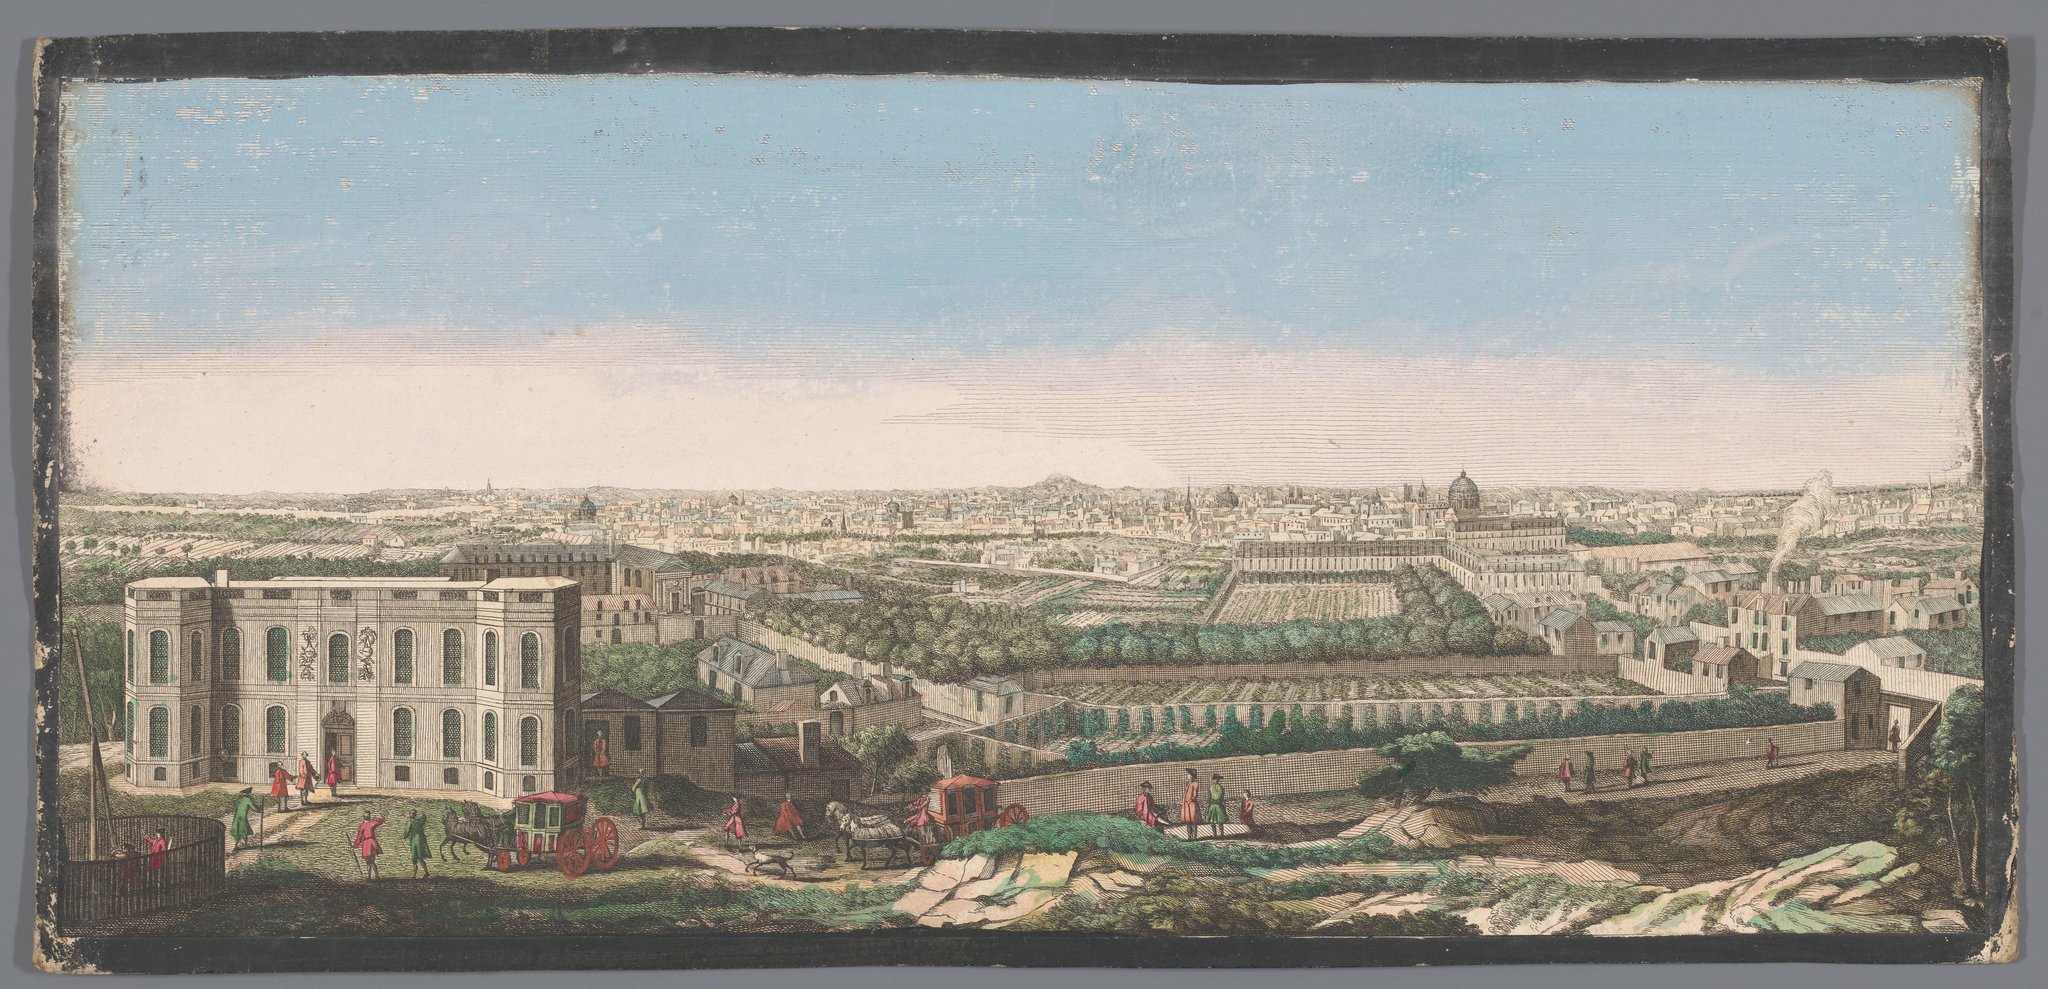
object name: opticaprent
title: Vuë générale de la ville de Paris, prise de la hauteur de l'Observatoire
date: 1700-1799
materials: cardboard, paper, watercolor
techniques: brush, etching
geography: paris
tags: city-view in general; 'veduta', meteorological observatory, paris